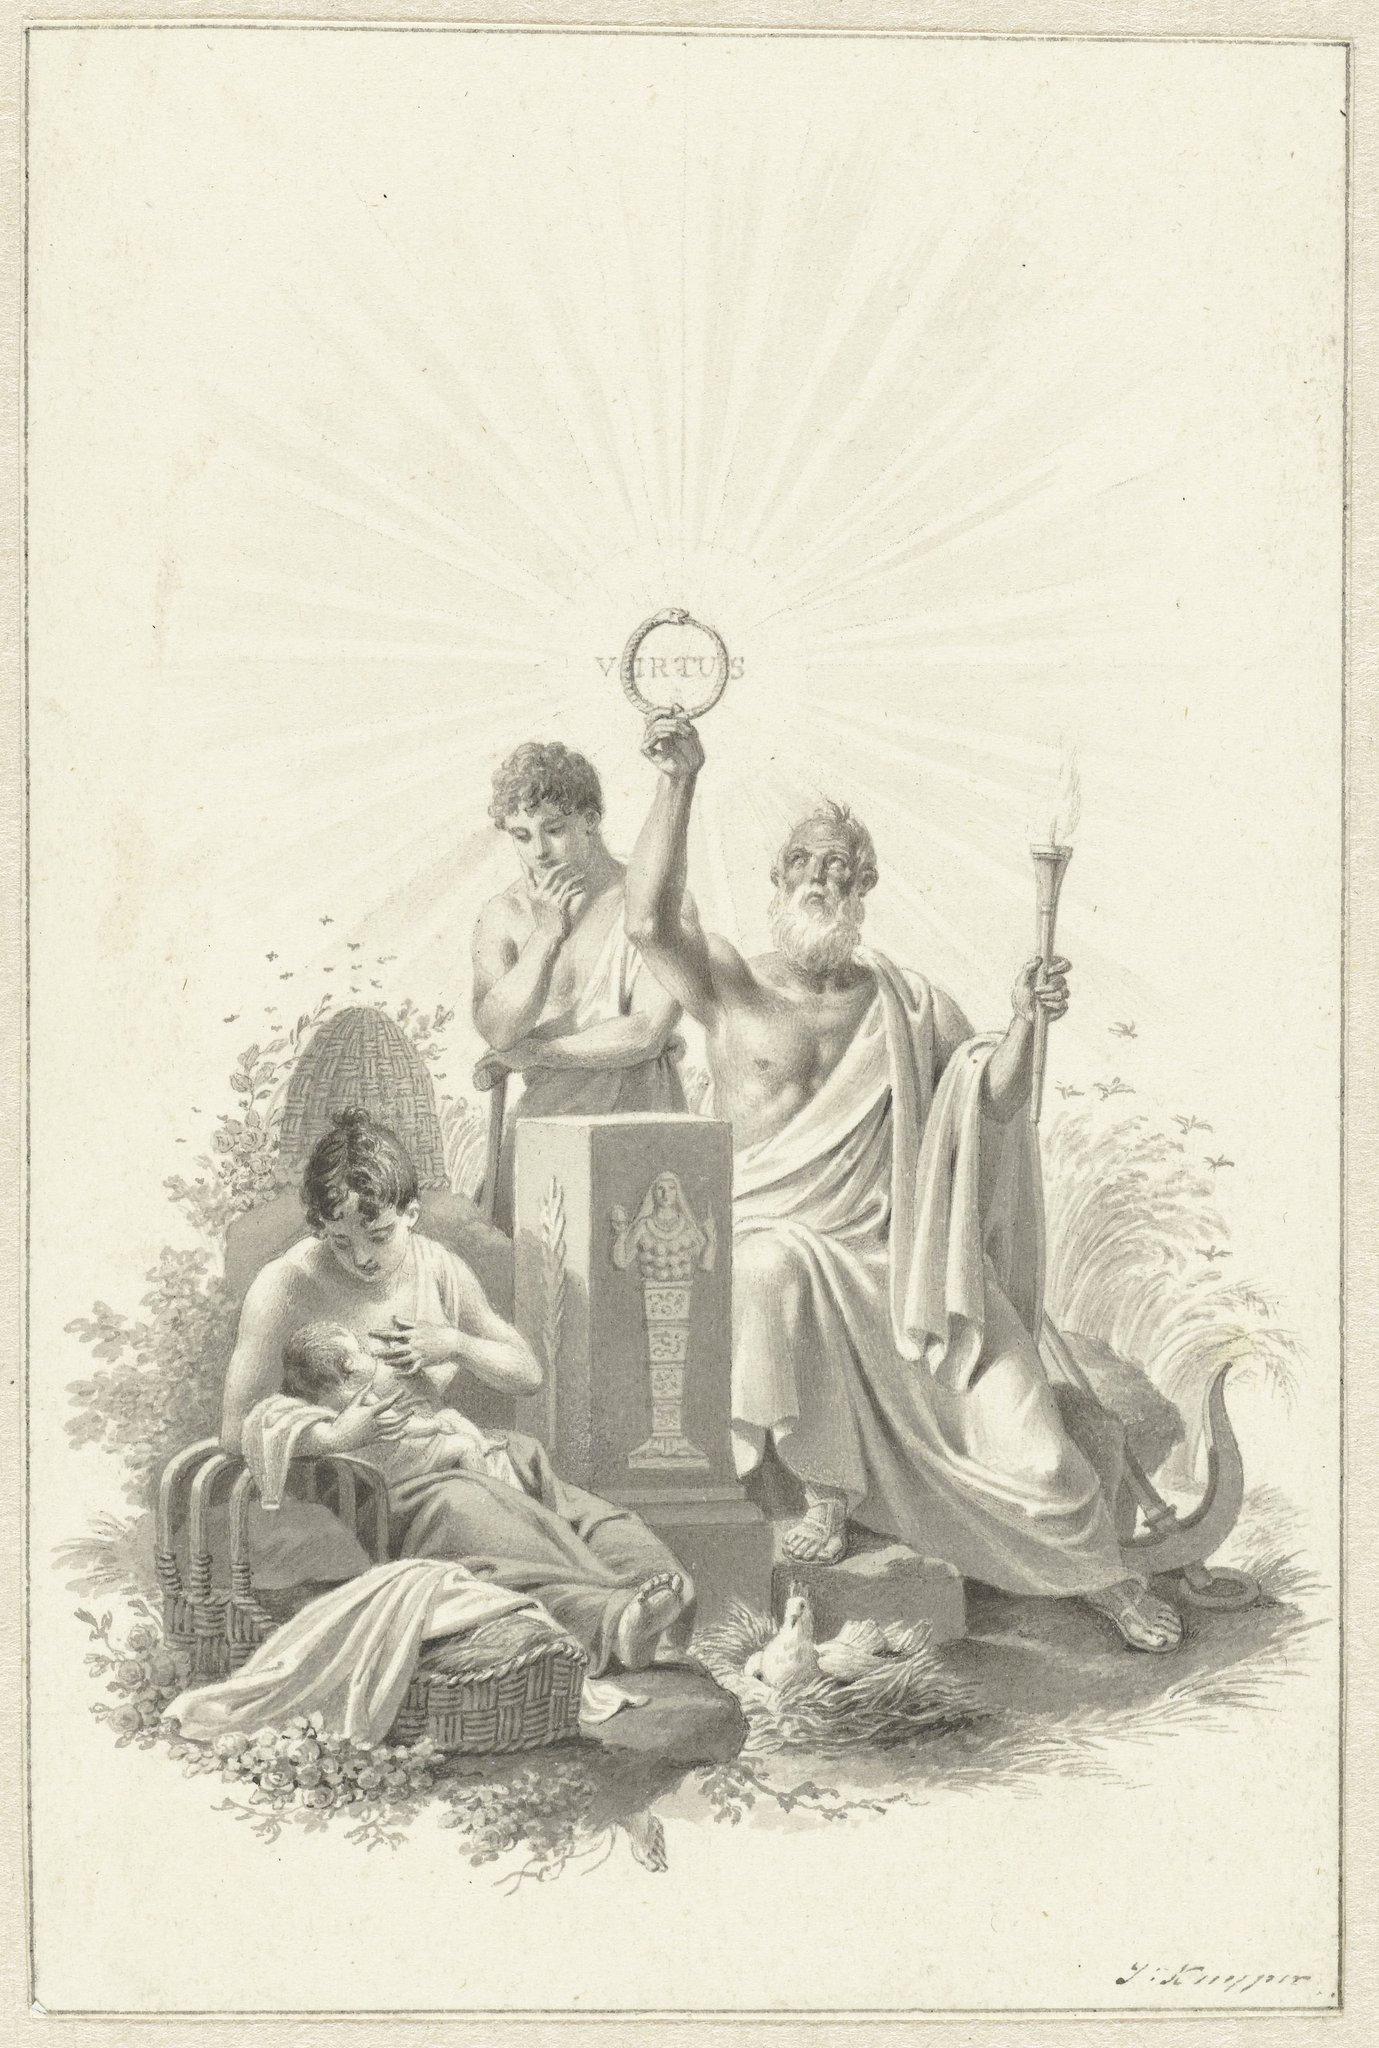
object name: design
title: Ontwerp voor titelblad voor W. Bilderdijk De Mensch, 1807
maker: jacques kuyper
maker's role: draughtsman, print maker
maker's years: 1761-1808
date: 1771-1807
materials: ink, paper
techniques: brush, pen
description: Ontwerp voor titelblad voor W. Bilderdijk "De Mensch", 1807